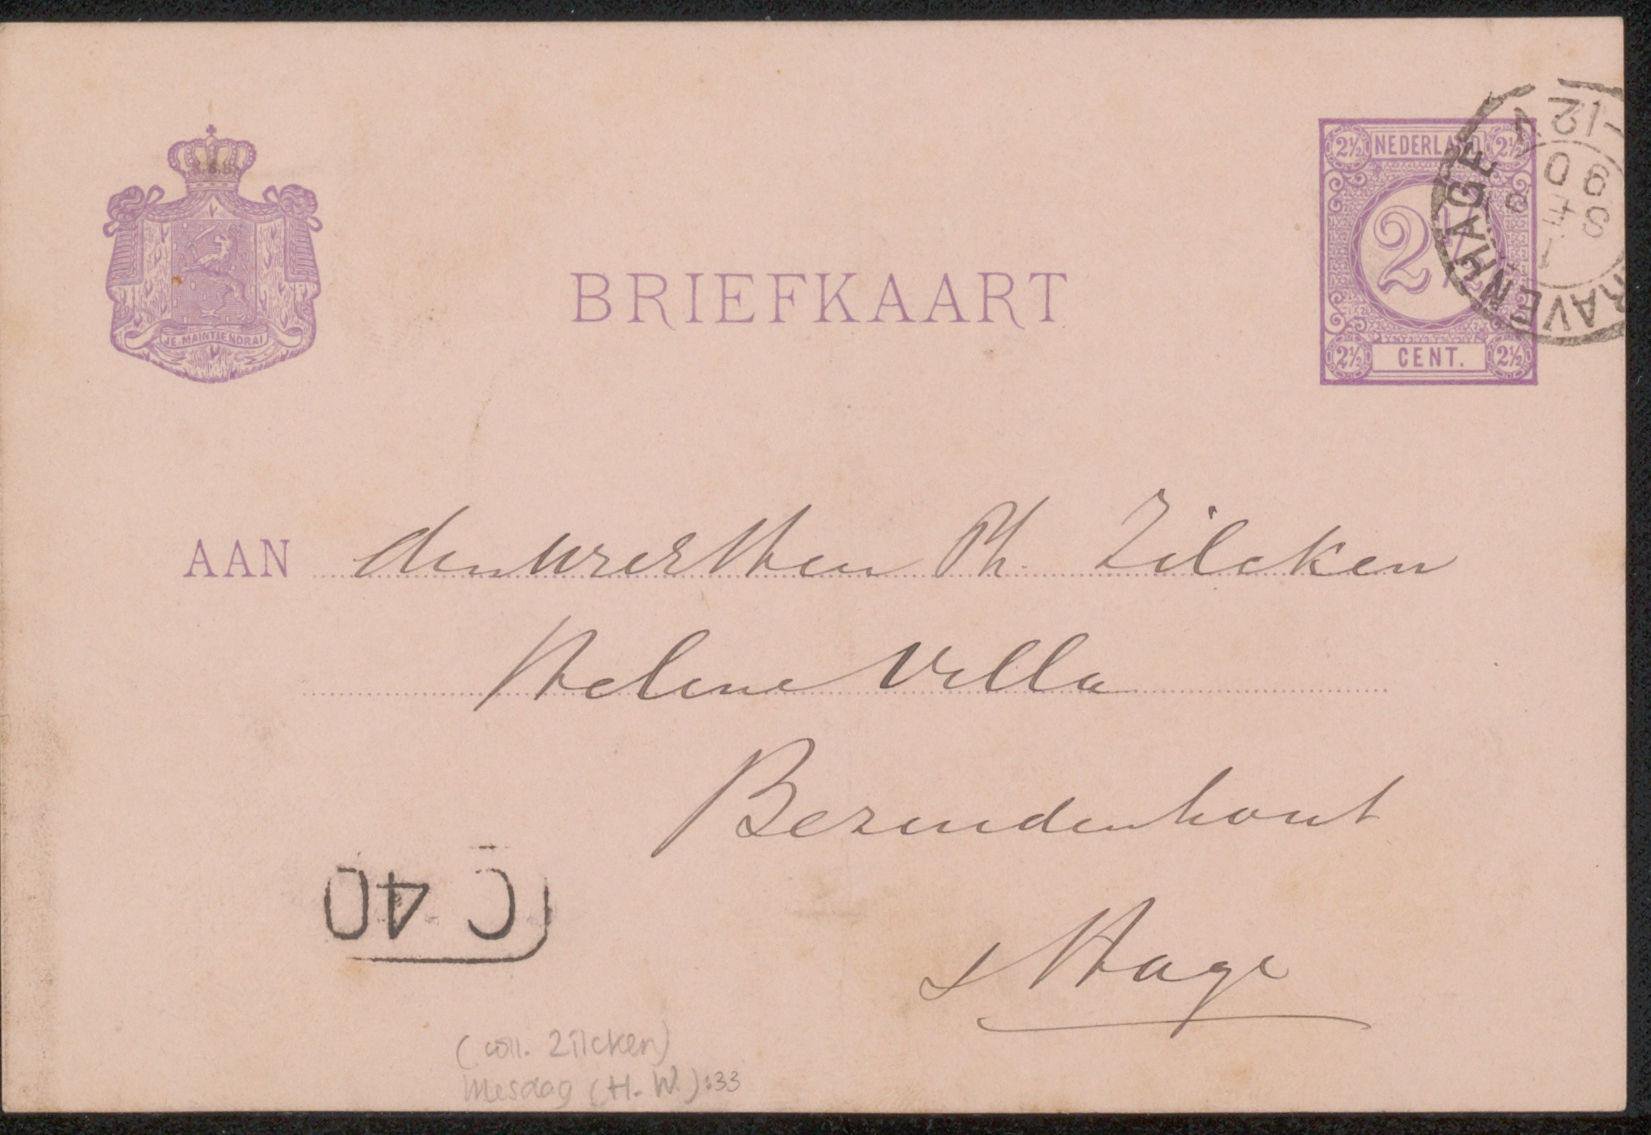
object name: postcard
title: Briefkaart aan Philip Zilcken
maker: hendrik willem mesdag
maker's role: draughtsman, painter, print maker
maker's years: 1831-1915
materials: cardboard, ink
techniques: pen, writing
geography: the hague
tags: philip zilcken